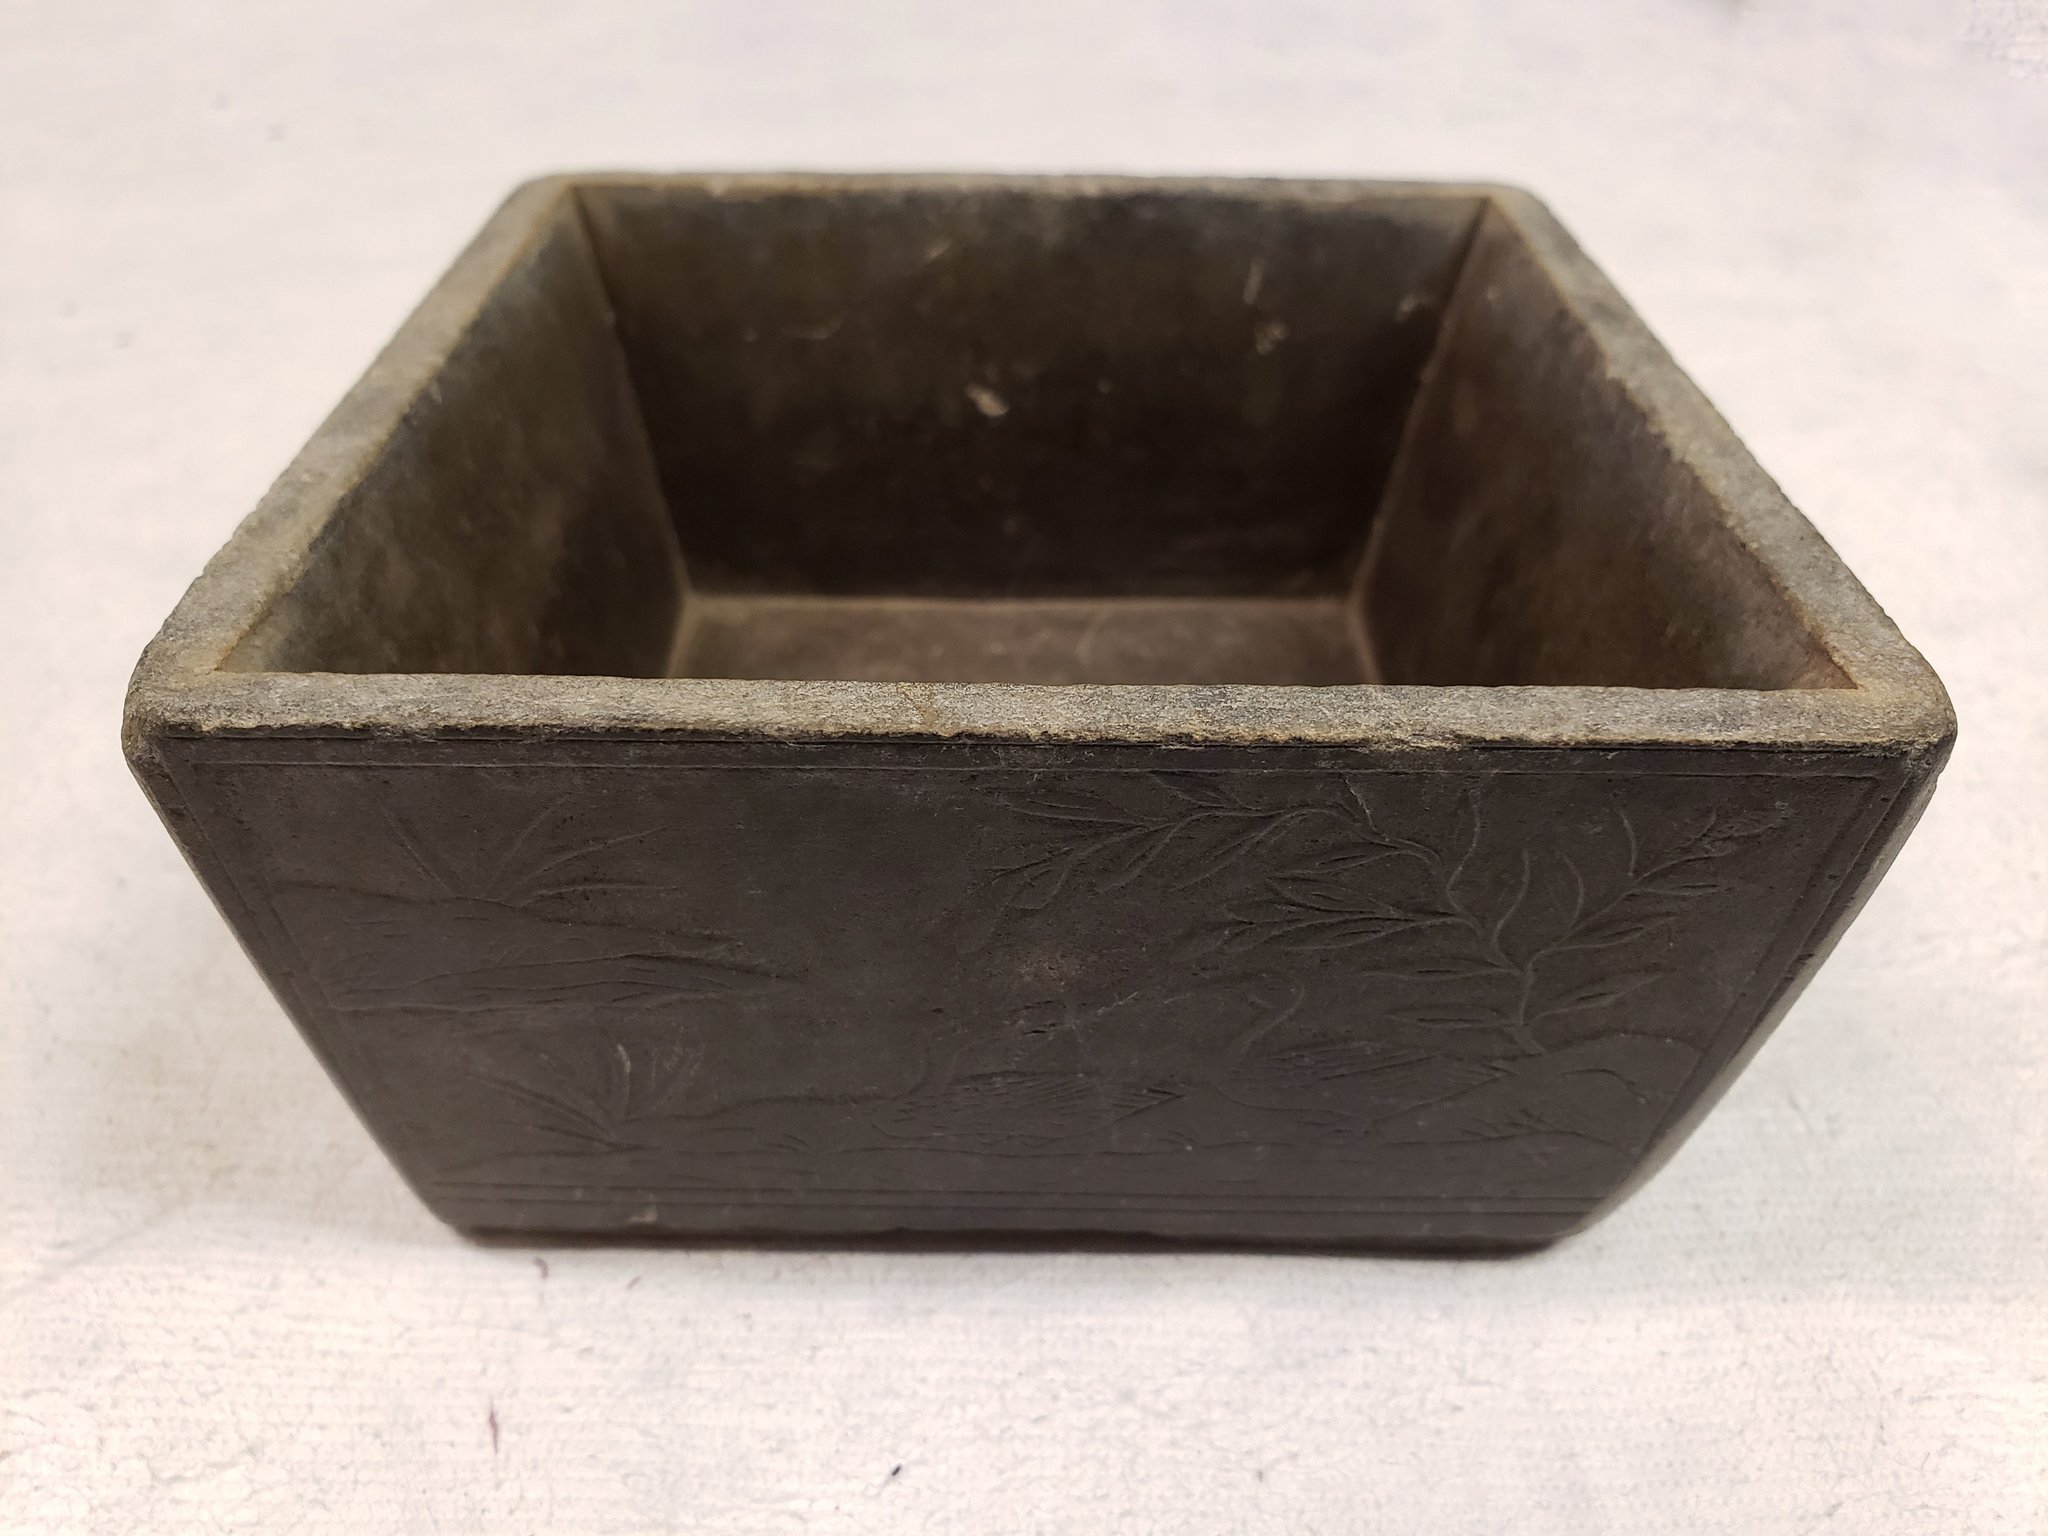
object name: water well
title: Water Well with Decoration of Water Fowl and Plants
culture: chinese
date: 1601-1700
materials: stone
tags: birds